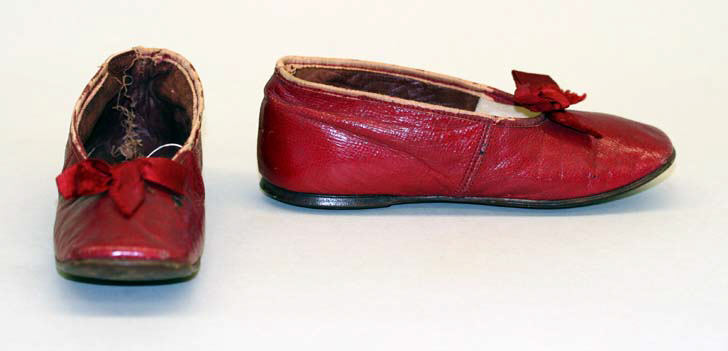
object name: shoe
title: Shoes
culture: american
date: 1834-1866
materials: leather